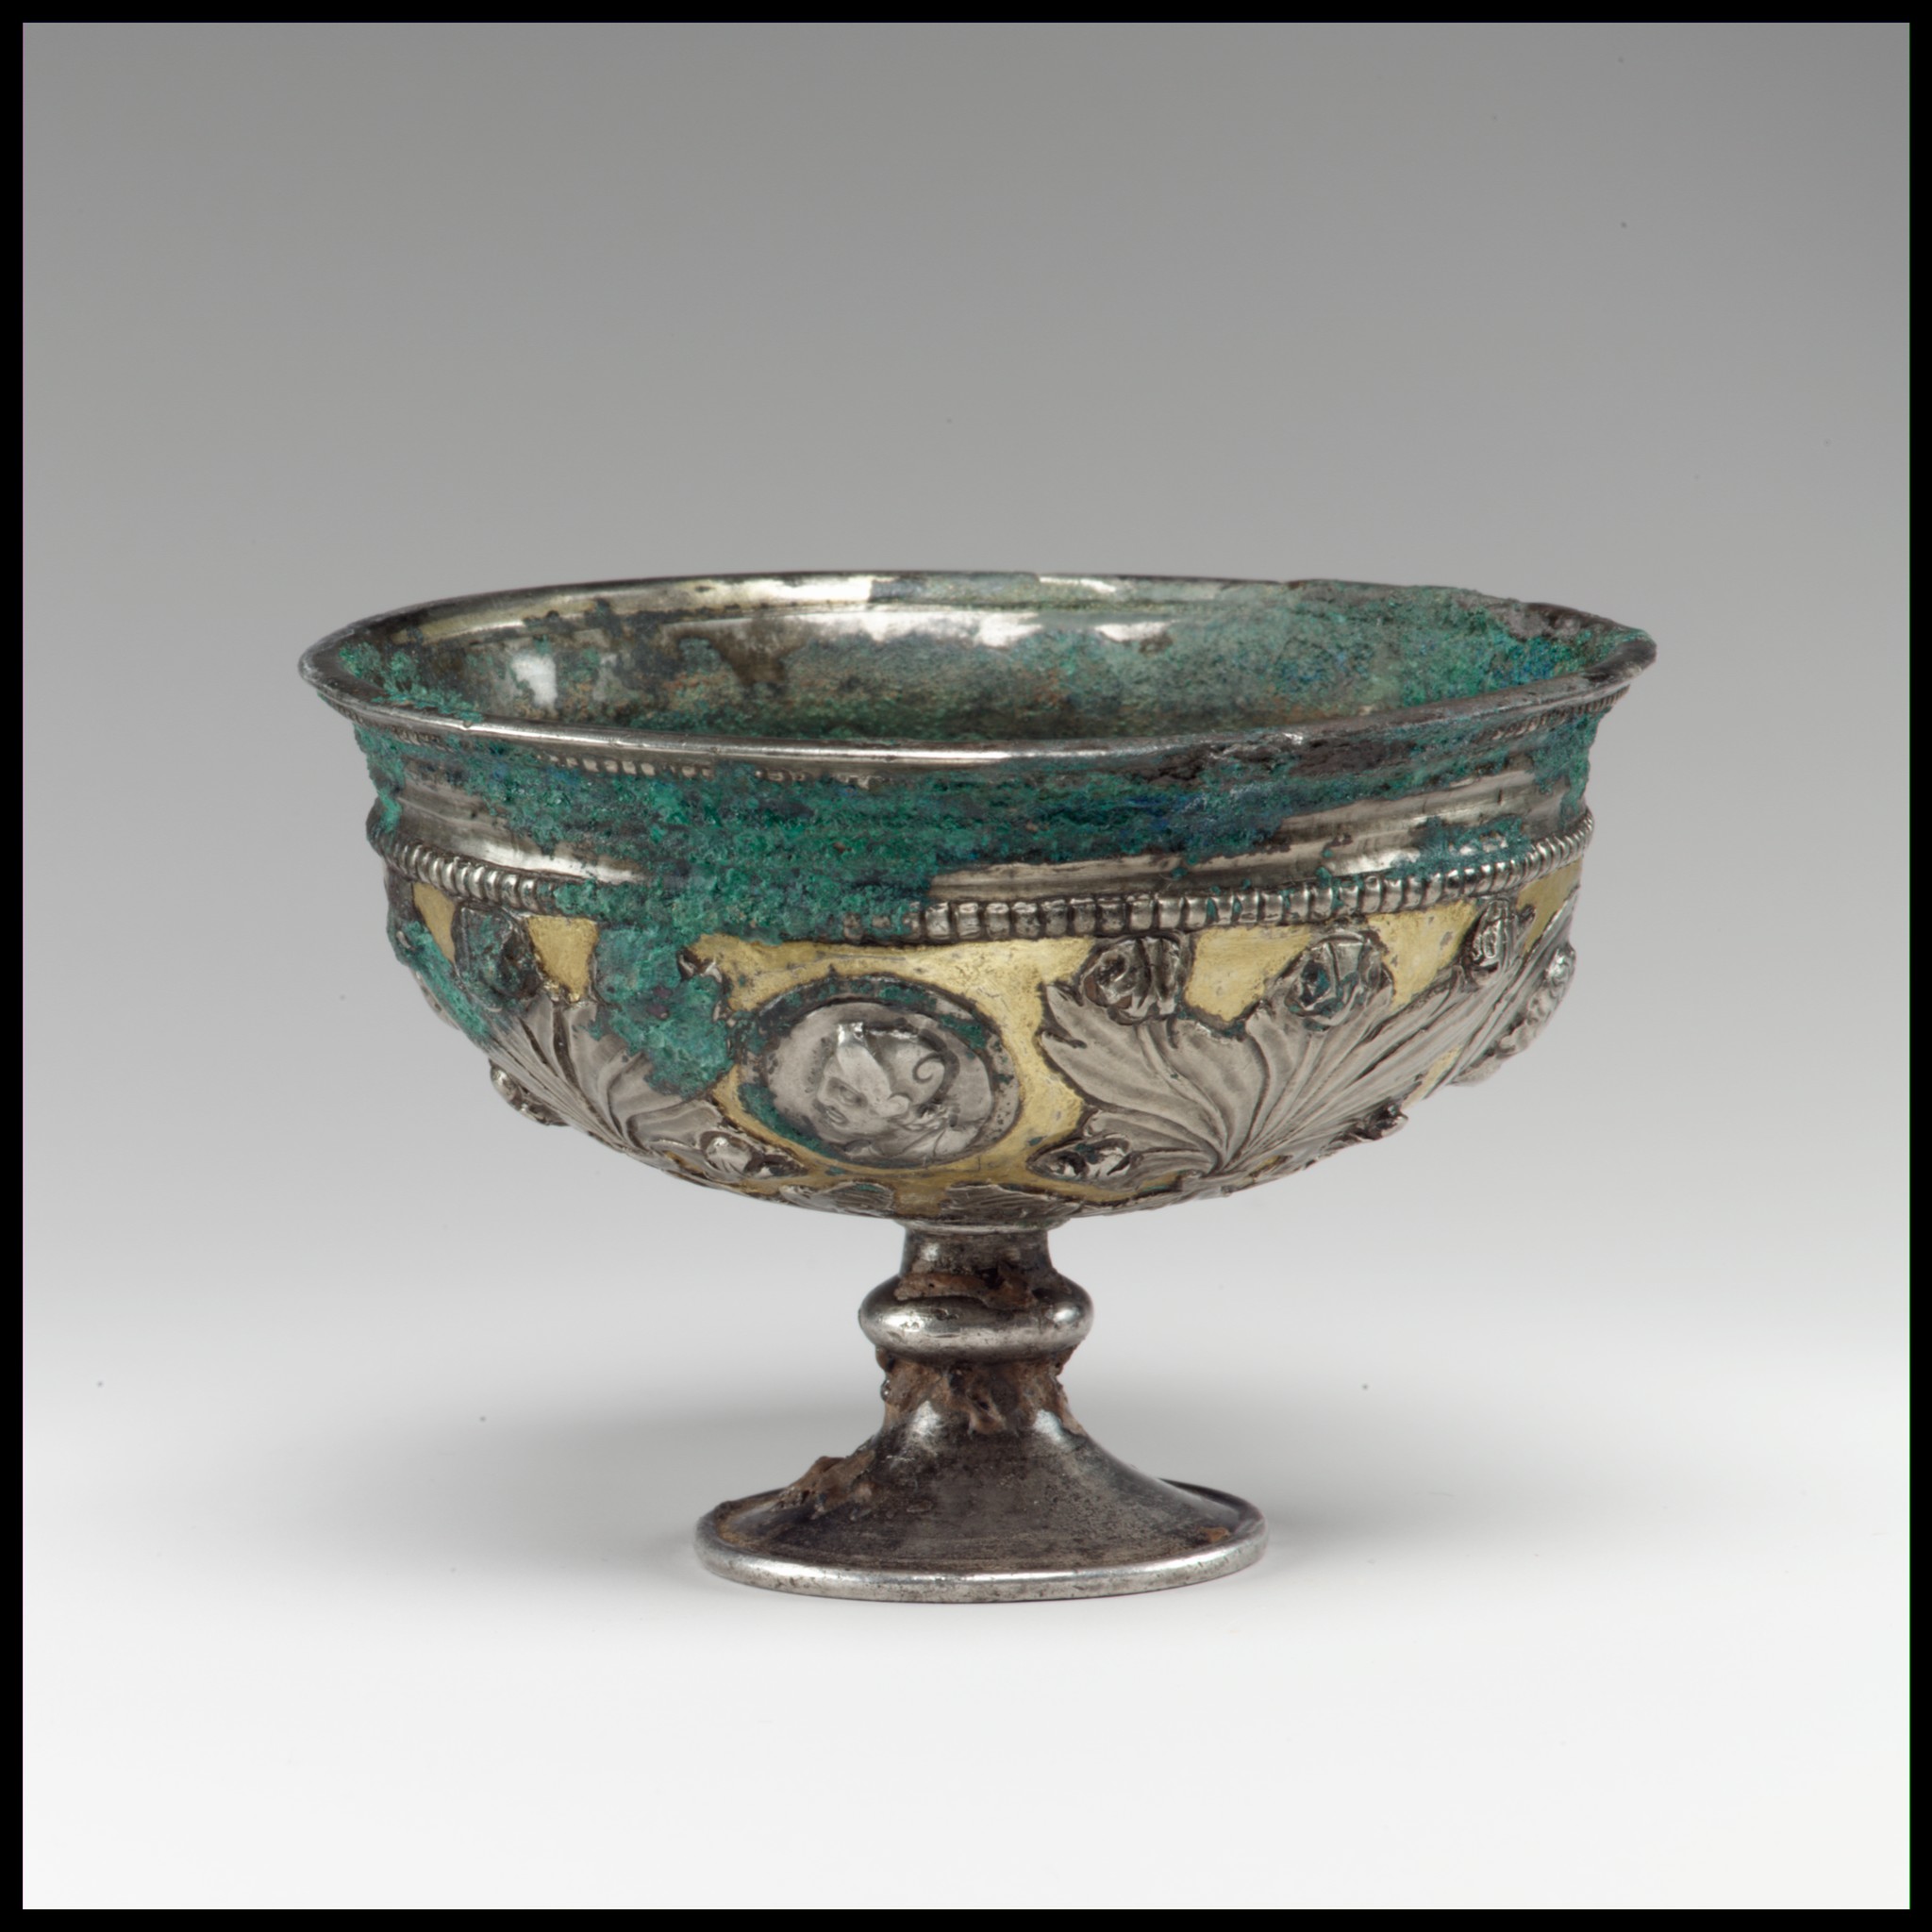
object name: cup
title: Footed cup with human busts in medallions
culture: kushano-sasanian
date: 201-400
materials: gilt, silver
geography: bactria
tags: medallions,men,profiles